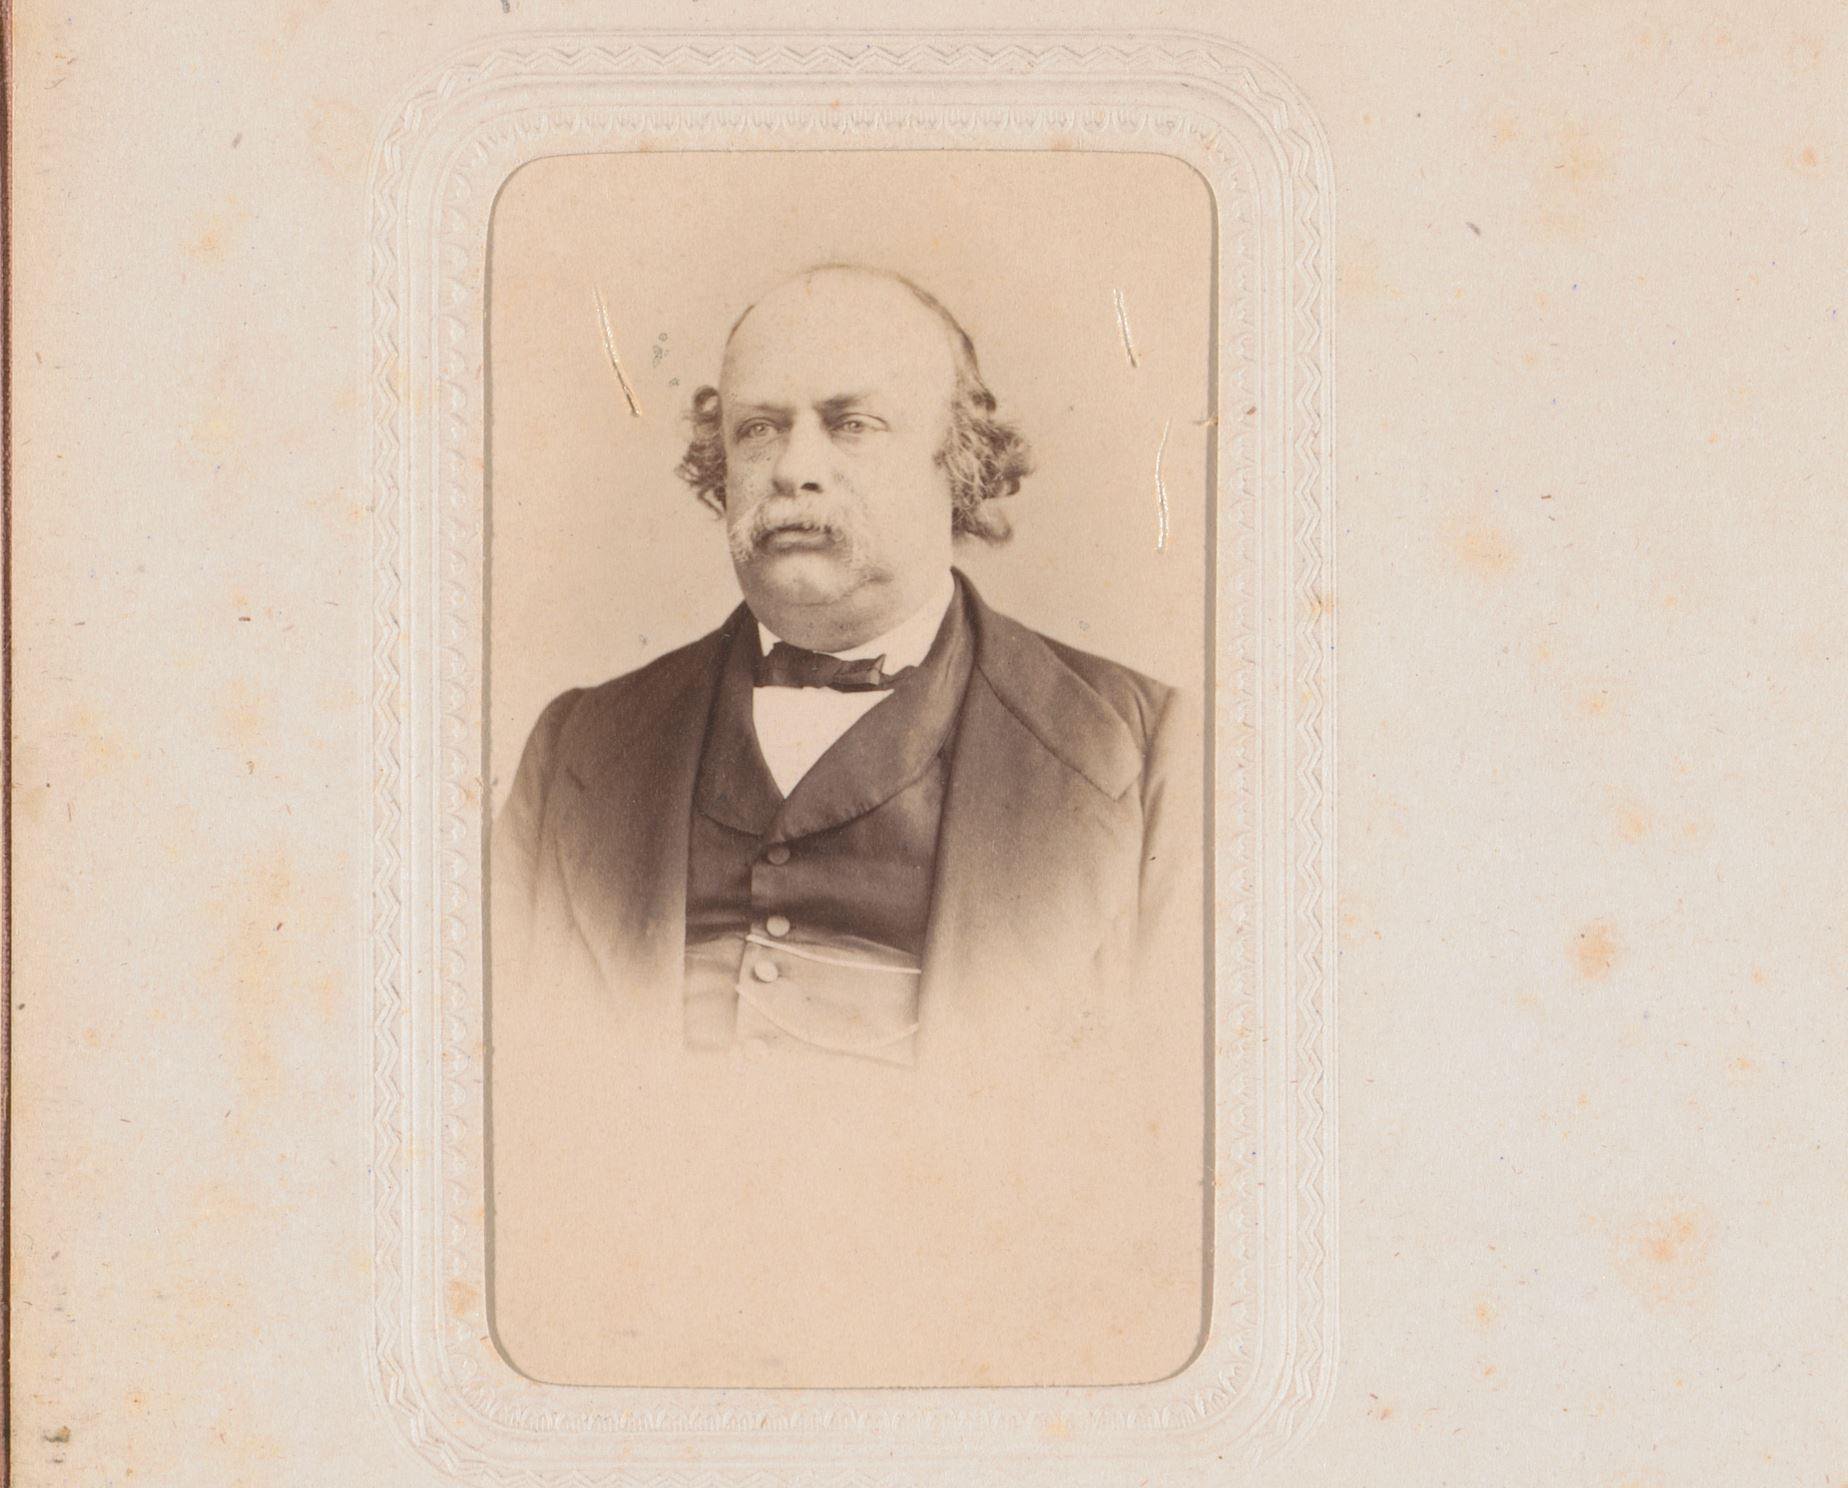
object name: photograph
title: Portret van een man, aangeduid als Rose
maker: maurits verveer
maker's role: painter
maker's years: 1817-1903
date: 1860-1870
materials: cardboard, photographic support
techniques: albumen print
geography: the hague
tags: historical persons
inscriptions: name: ‘Rose’, inscription: ‘M. VERVEER/ PHOTOGRAPHE/ DE LL.M.M. KE ROI ET LA REINE DES PAYS-BAS./ 52, Zeestraat, vis à vis du Willemspark./ LA HAYE.’, name: ‘Rose’